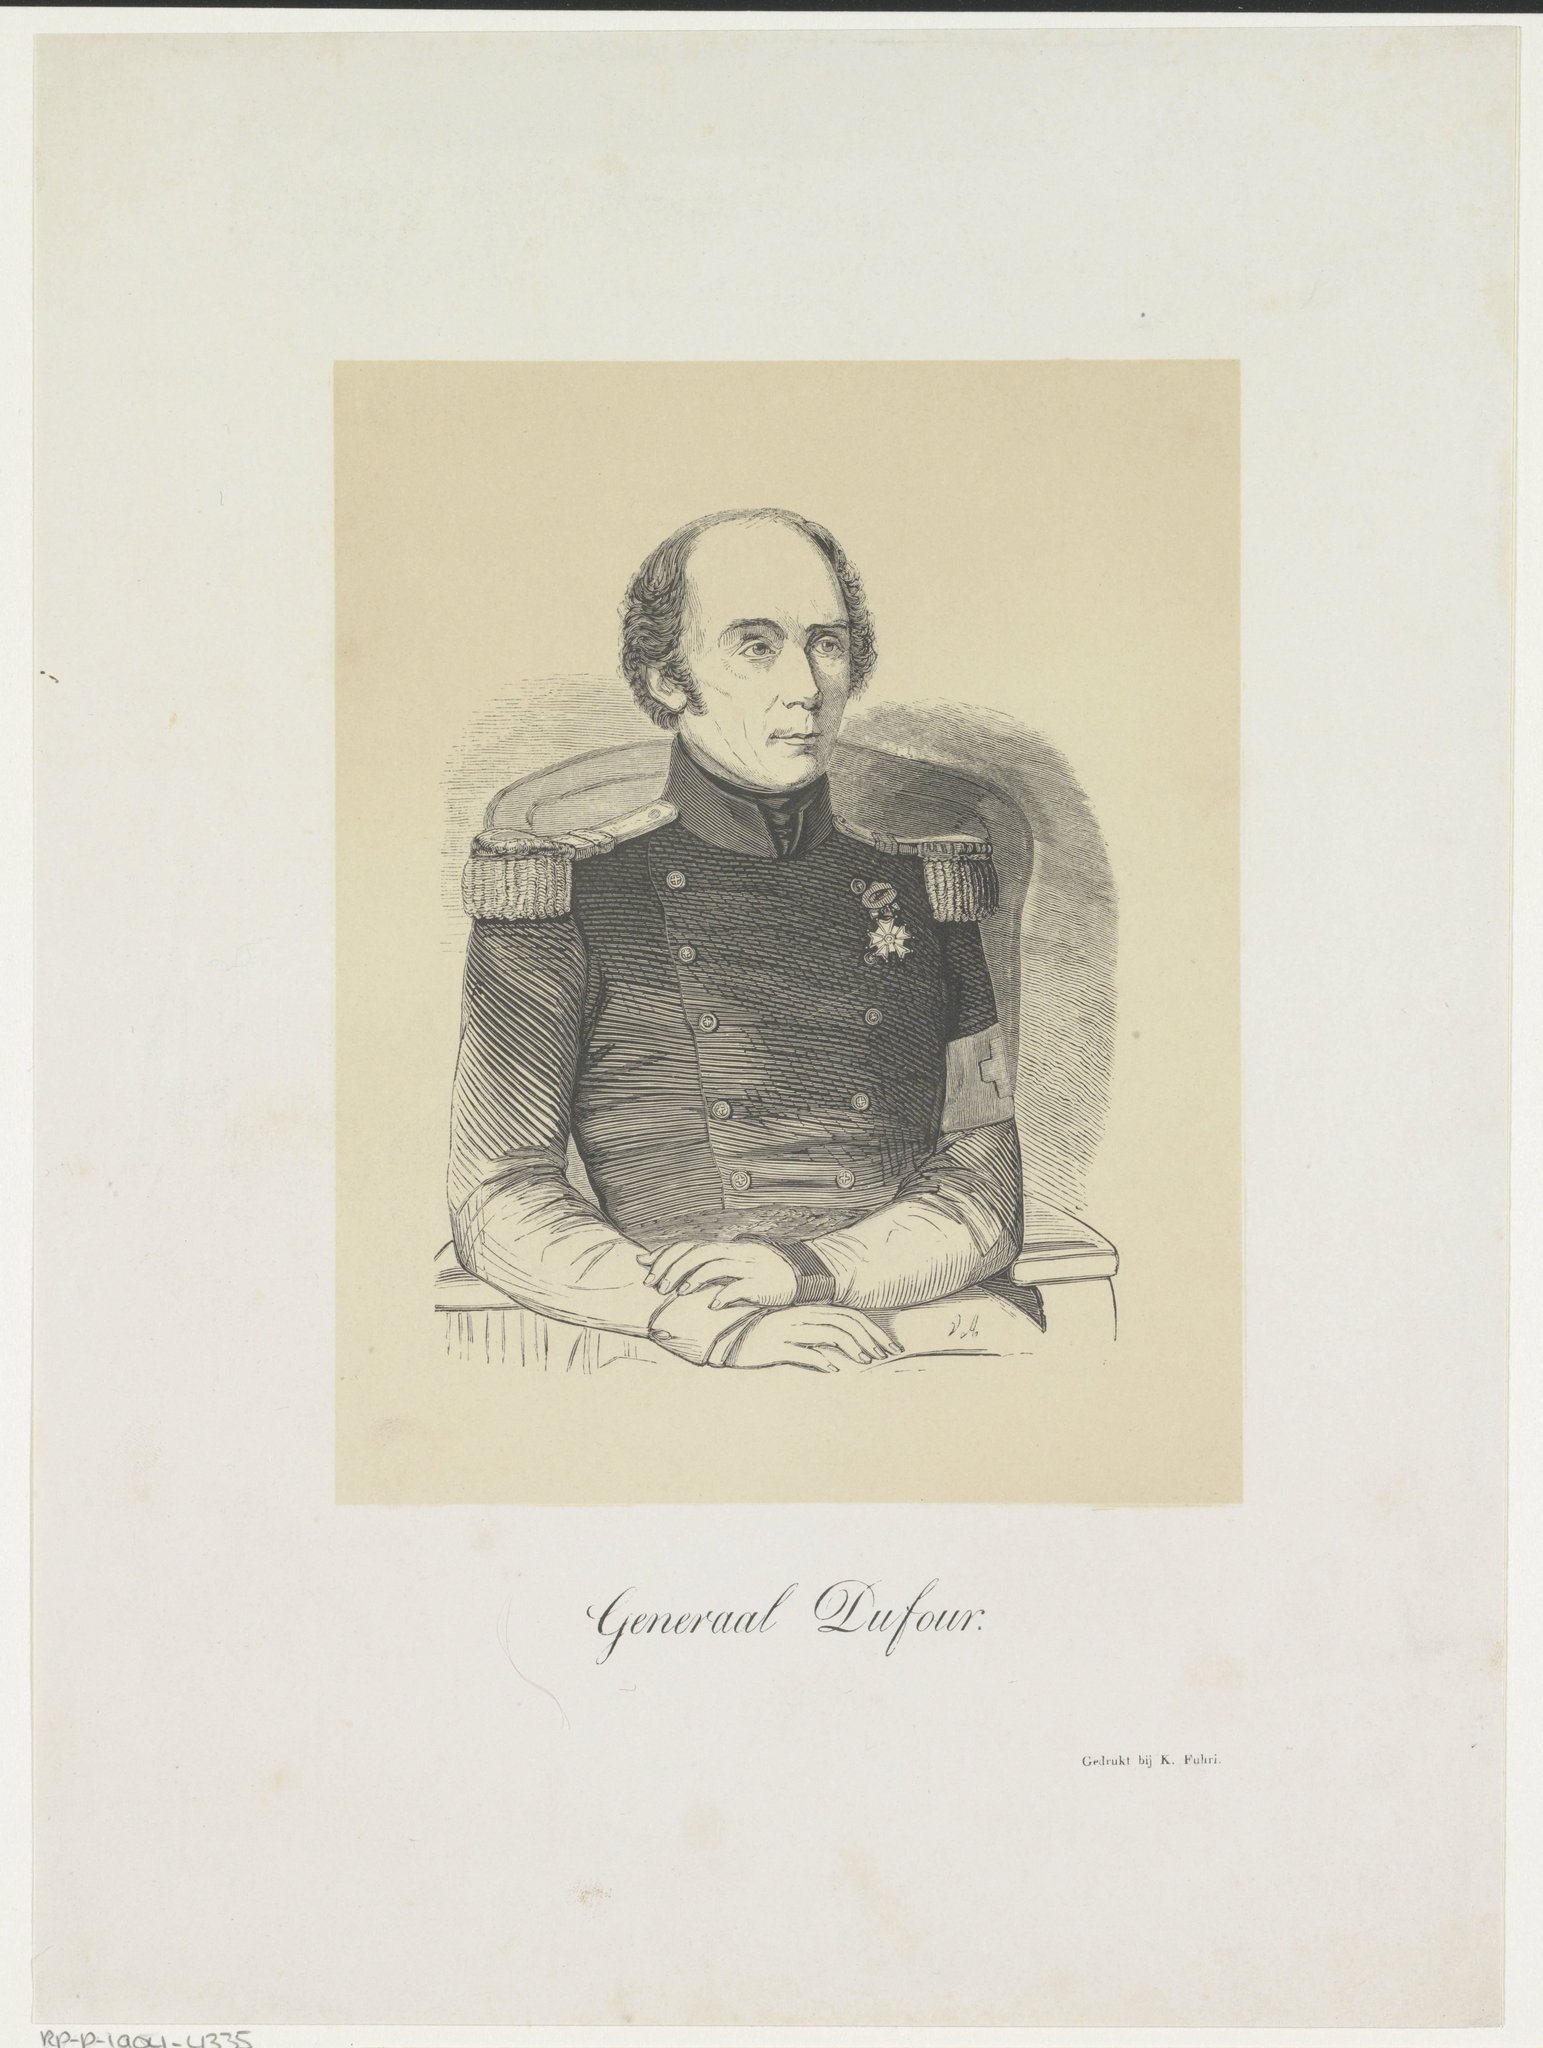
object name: print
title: Portret van Guillaume Henri Dufour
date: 1824-1858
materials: paper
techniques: engraving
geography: netherlands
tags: genève, guillaume henri dufour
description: Portret van Guillaume Henri Dufour. In de ondermarge zijn naam en titel.